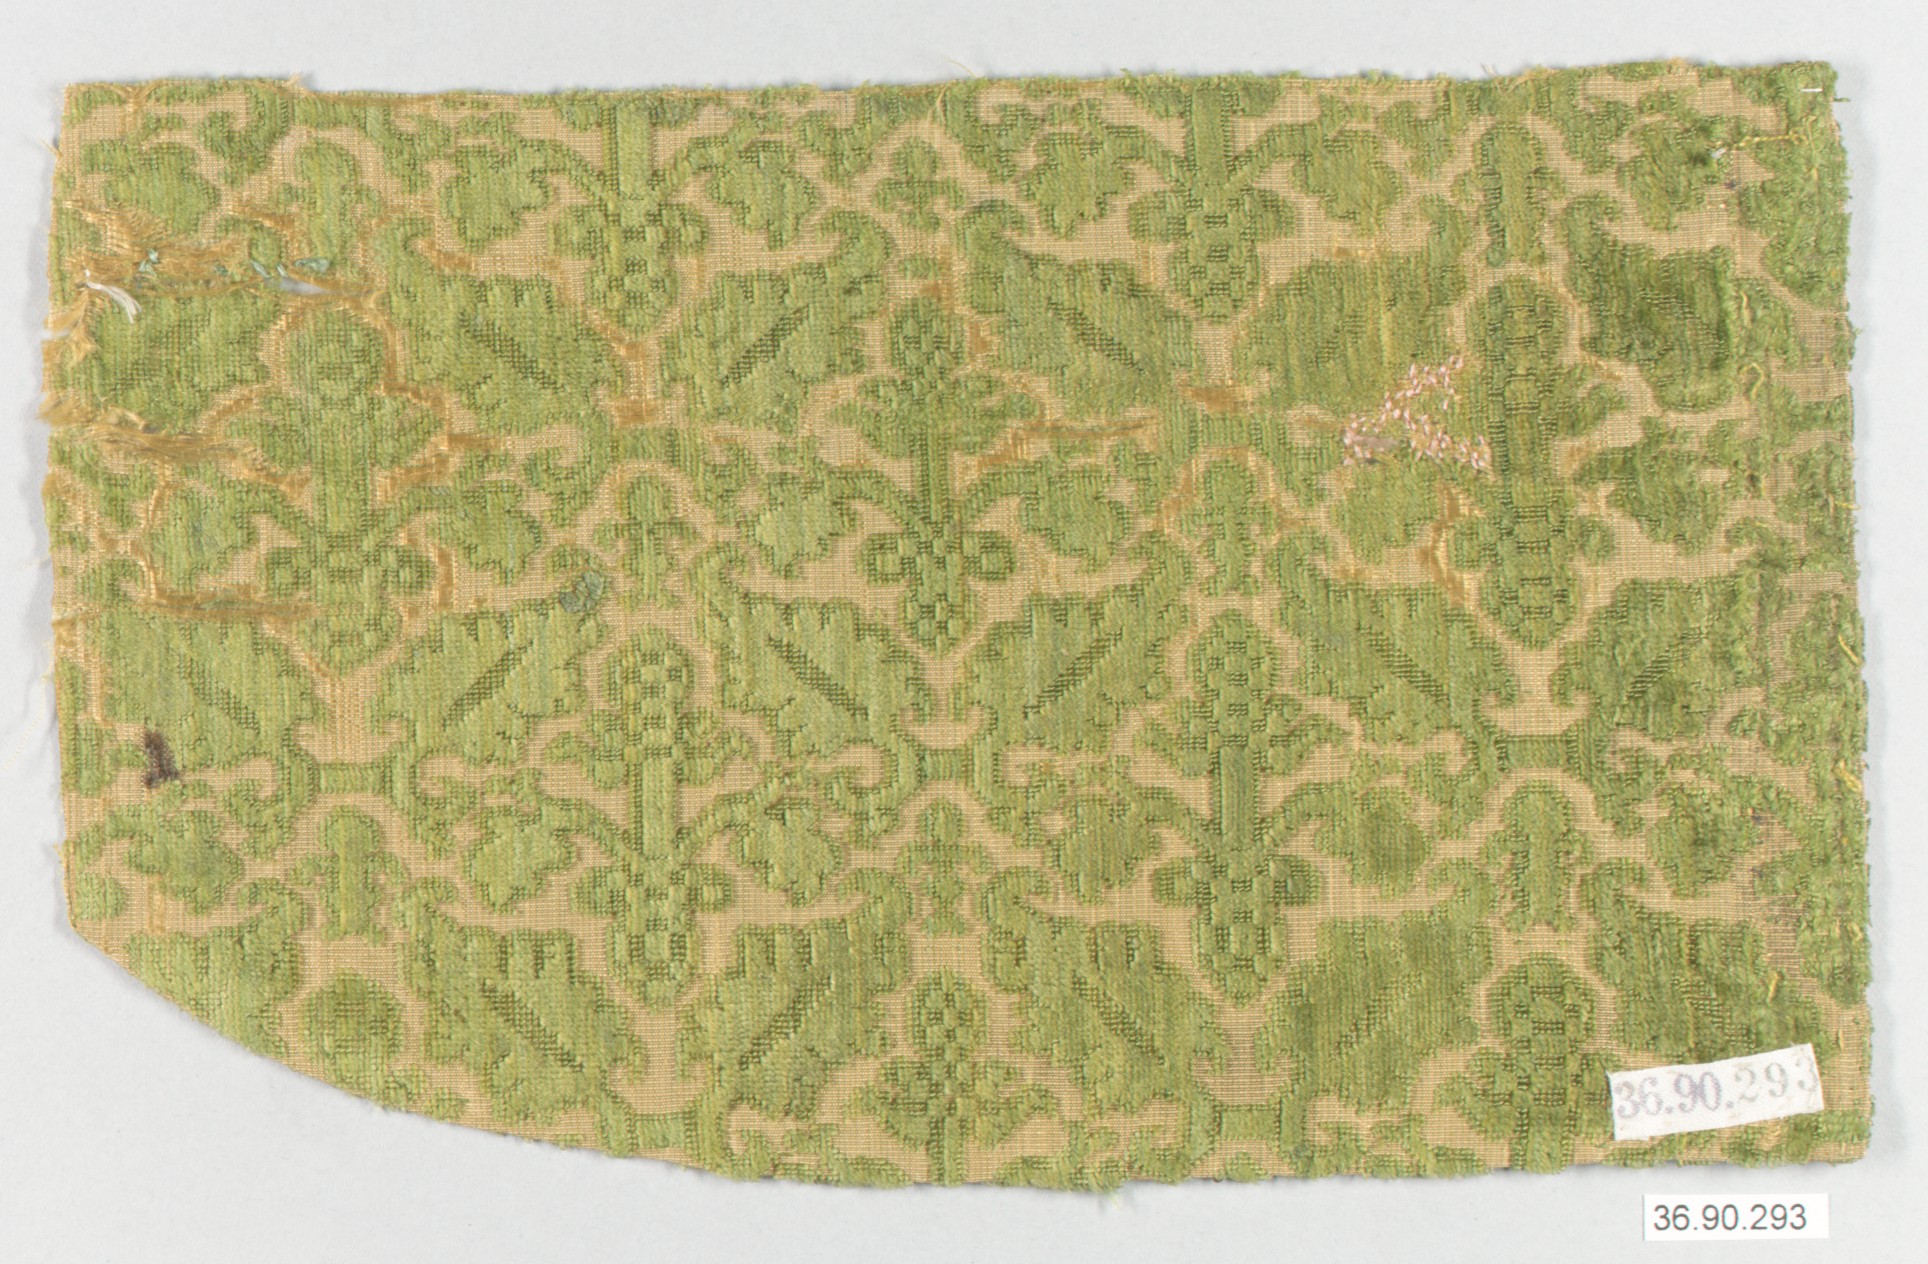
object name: piece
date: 1501-1700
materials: silk